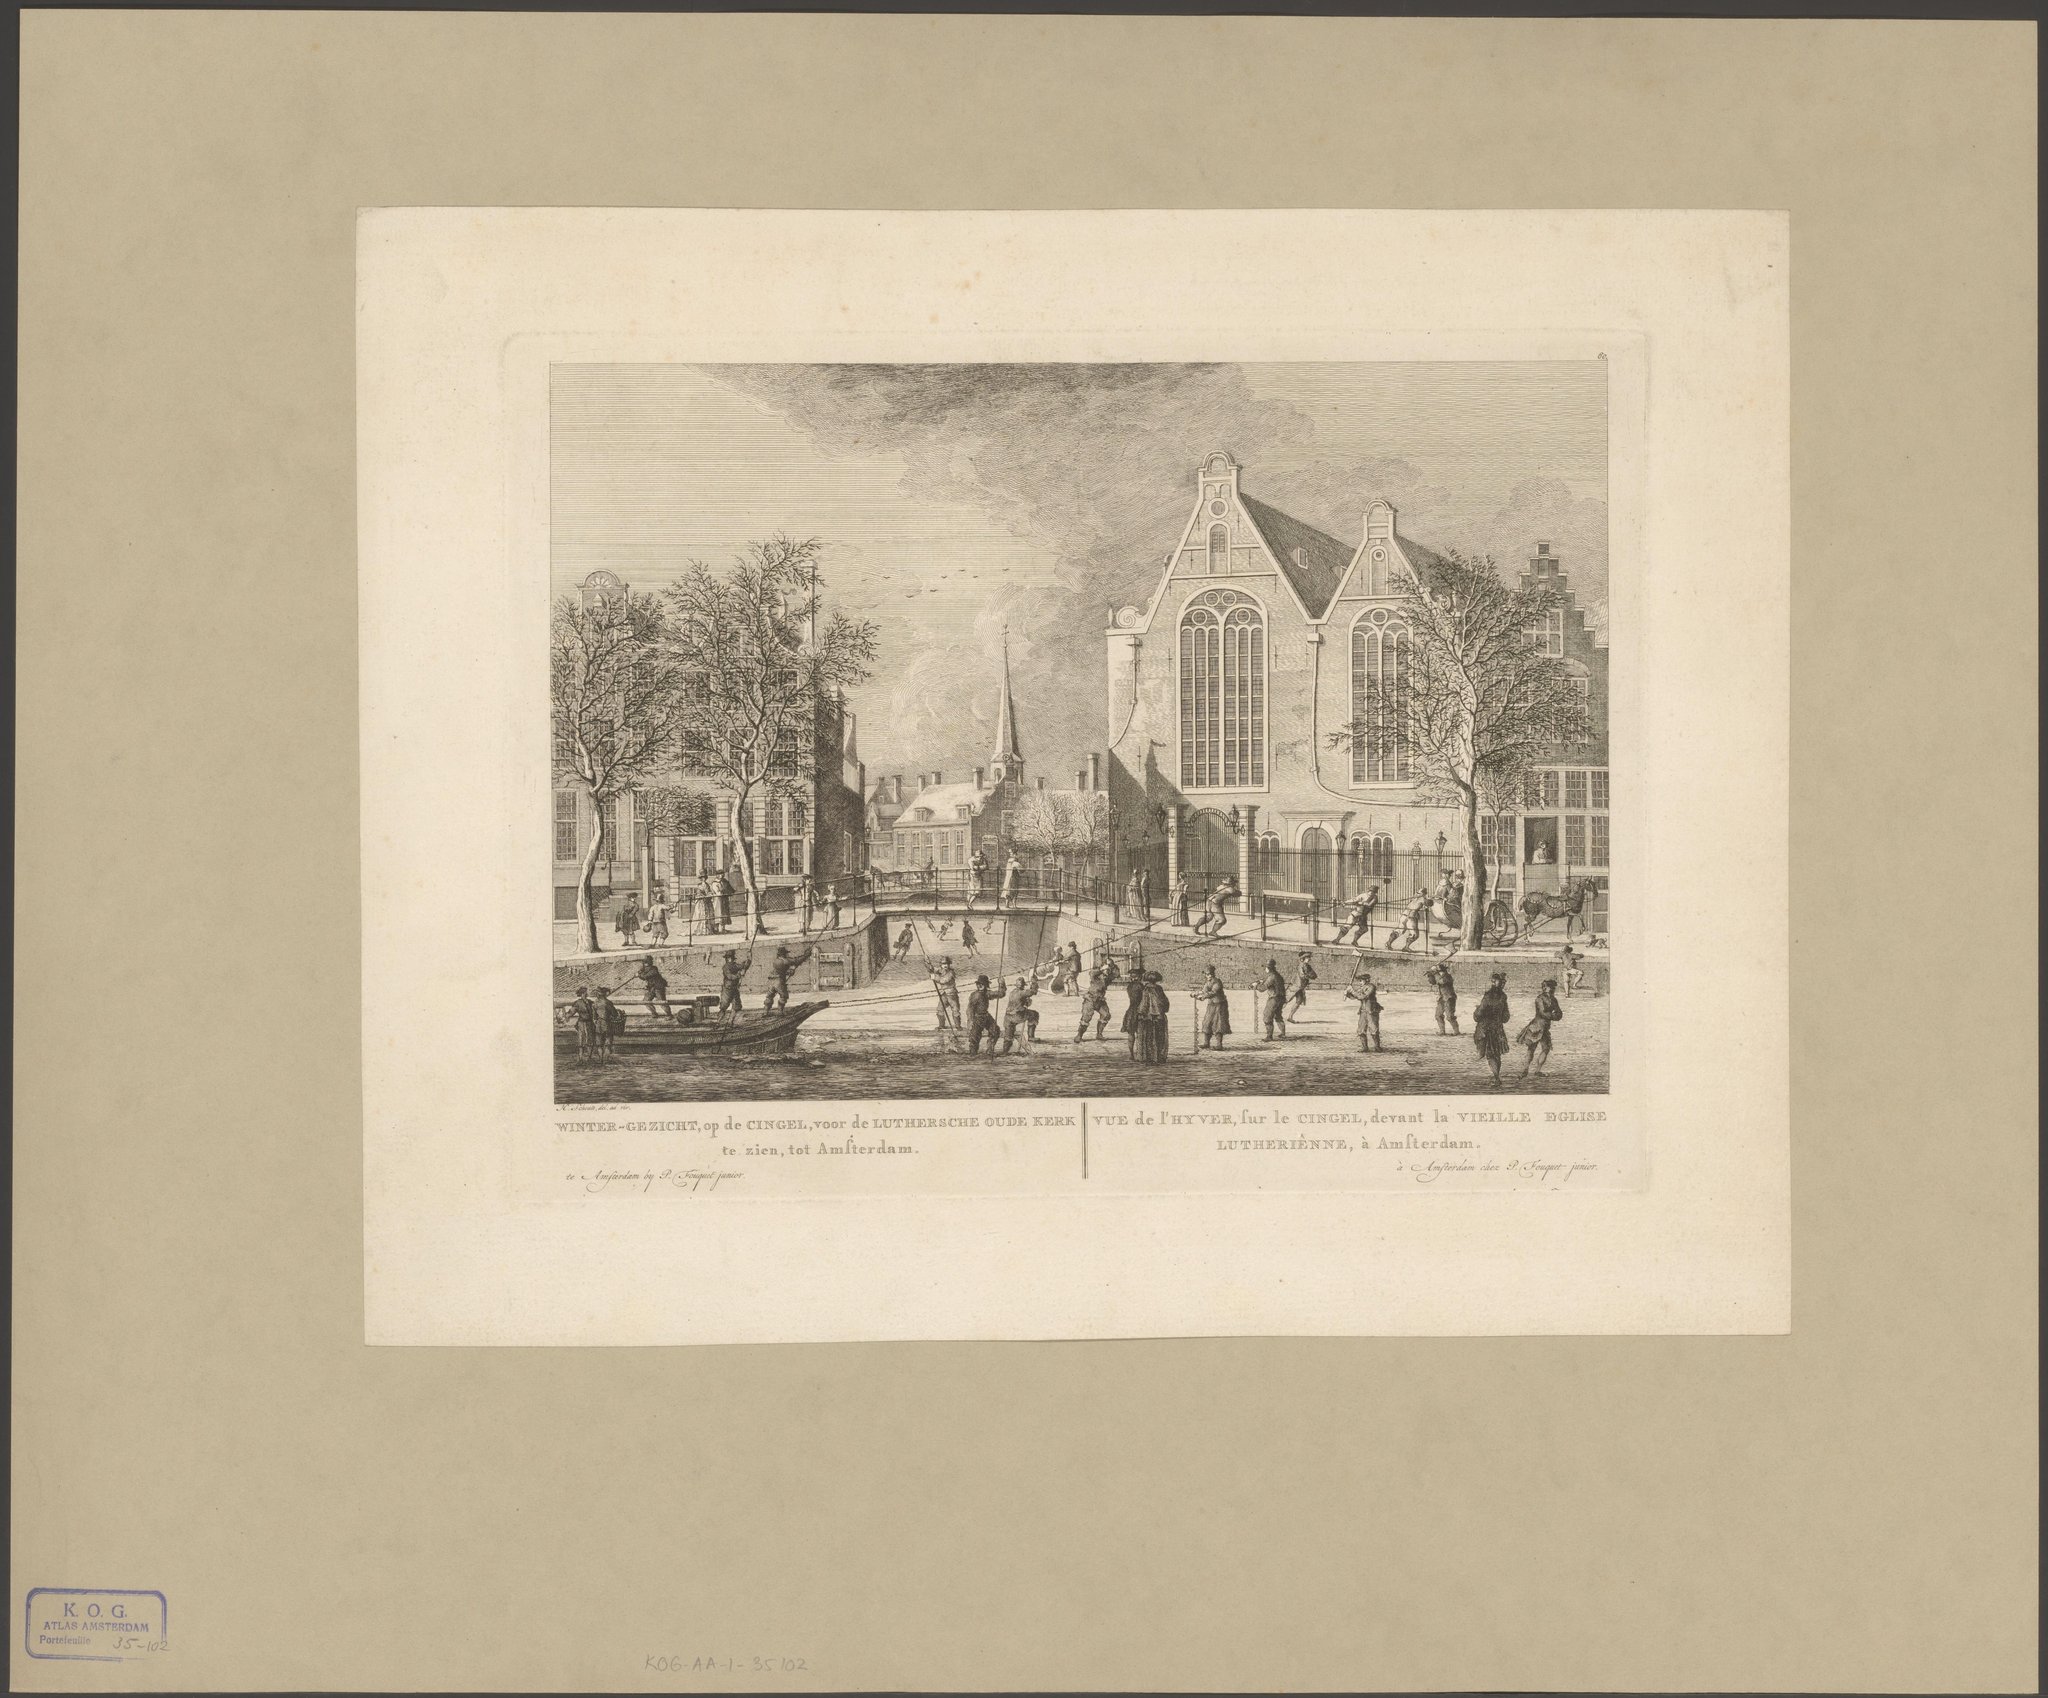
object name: print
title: Winter-Gezicht, op de Cingel, voor de Luthersche Oude Kerk te zien, tot Amsterdam / Vue de l'hyver, sur le Cingel, devant la Vieille Eglise Lutheriênne, à Amsterdam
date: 1770-1783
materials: paper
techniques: engraving, etching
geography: amsterdam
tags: protestant churches and denominations (lutherans), winter ~ human activities (the four seasons of the year), church (exterior), skates (winter sports), canals, waters (in city)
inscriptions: collector's mark: ‘35-102’ Lugt 1641b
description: Deze prent is ook gebruikt in de zogenaamde Atlas van Fouquet.* Pierre Fouquet gaf vanaf 1760 stadsgezichten van Amsterdam - naar tekeningen van verschillende kunstenaars, gemaakt door verschillende prentmakers - uit. Deze prenten werden aanvankelijk los of in series verkocht. Zoals toen gebruikelijk kon de koper de prenten zelf laten inbinden. Hiertoe gaf Fouquet tussen 1778 en 1783 een titelblad, plattegrond en inhoudsopgave van de tot dusver 100 uitgegeven prenten uit (1). Gezien de inhoud afhankelijk was van wat de koper had verzameld verschilt de inhoud van de verschillende bewaarde Fouquetatlassen onder deze titel sterk. Ook zijn er exemplaren bekend waar tevens andere prenten aan zijn toegevoegd. Omdat er behoefte bleek aan uitleg bij de platen werd in 1783 een nieuwe versie van de atlas uitgegeven, aangevuld met tekst en twee prenten. De aangegeven volgorde veranderde maar de platen van de al eerder uitgegeven prenten bleven ongewijzigd. Deze uitgave werd in opdracht van Fouquet gedrukt bij Daniël Jean Changuion en Petrus den Hengst (2). Een tiental platen werd bijgewerkt en verscheen, met nieuw impressum, in het vervolg van Wagenaars geschiedenis van Amsterdam, uitgeven door Petrus Conradi en Folkert van der Plaats (3). Een aantal jaar na het overlijden van Fouquet kwam Evert Maaskamp met een nieuwe uitgave van de atlas, met verbeterde tekst en toevoeging van twee prenten. Op alle platen verwijderde hij het oude en liet hij zijn eigen impressum zetten (4). De huidige staat van de prent komt voor in exemplaren van de onder (1) en (2) genoemde werken. * Onder de Atlas van Fouquet of Fouquetatlas verstaan we de hieronder vermelde publicaties (1), (2) en (4). (1). Afbeeldingen van de wyd-vermaarde koopstad Amsterdam benevens des zelvs voornaamste gebouwen en gezigten alle naar het leeven getekend / Receuil des edifices les plus considerables et des plus belles vues, de la fameuse ville d'Amsterdam, dessinées d'après nature. Amsterdam: Pierre Fouquet, 1778-1783. (2). Nieuwe atlas, van de voornaamste gebouwen en gezigten der stad Amsterdam, met derzelver beknopte beschryvingen. 2 dln. Amsterdam: Daniël Jean Changuion en Petrus den Hengst [in opdracht van Pierre Fouquet], 1783. (3). Stijl, Simon. Amsterdam, in zyne geschiedenissen, voorregten, koophandel, gebouwen, kerkenstaat, schoolen, schutterye, gilden en regeeringe, beschreeven. Om te dienen ten vervolge op het werk van Jan Wagenaar (…). 10 dln. Amsterdam en Harlingen: Petrus Conradi en Folkert van der Plaats, 1788-1801. (4). Nieuwe atlas, van de voornaamste gebouwen en gezigten der stad Amsterdam. Met derzelver beknopte beschryvingen. Amsterdam: Evert Maaskamp, 1805. * Het aantal vermelde staten is gebaseerd op het aantal gevonden staten. Mogelijk zijn er meer staten van deze prent. Zie RP-P-AO-24-1AX voor latere staat.